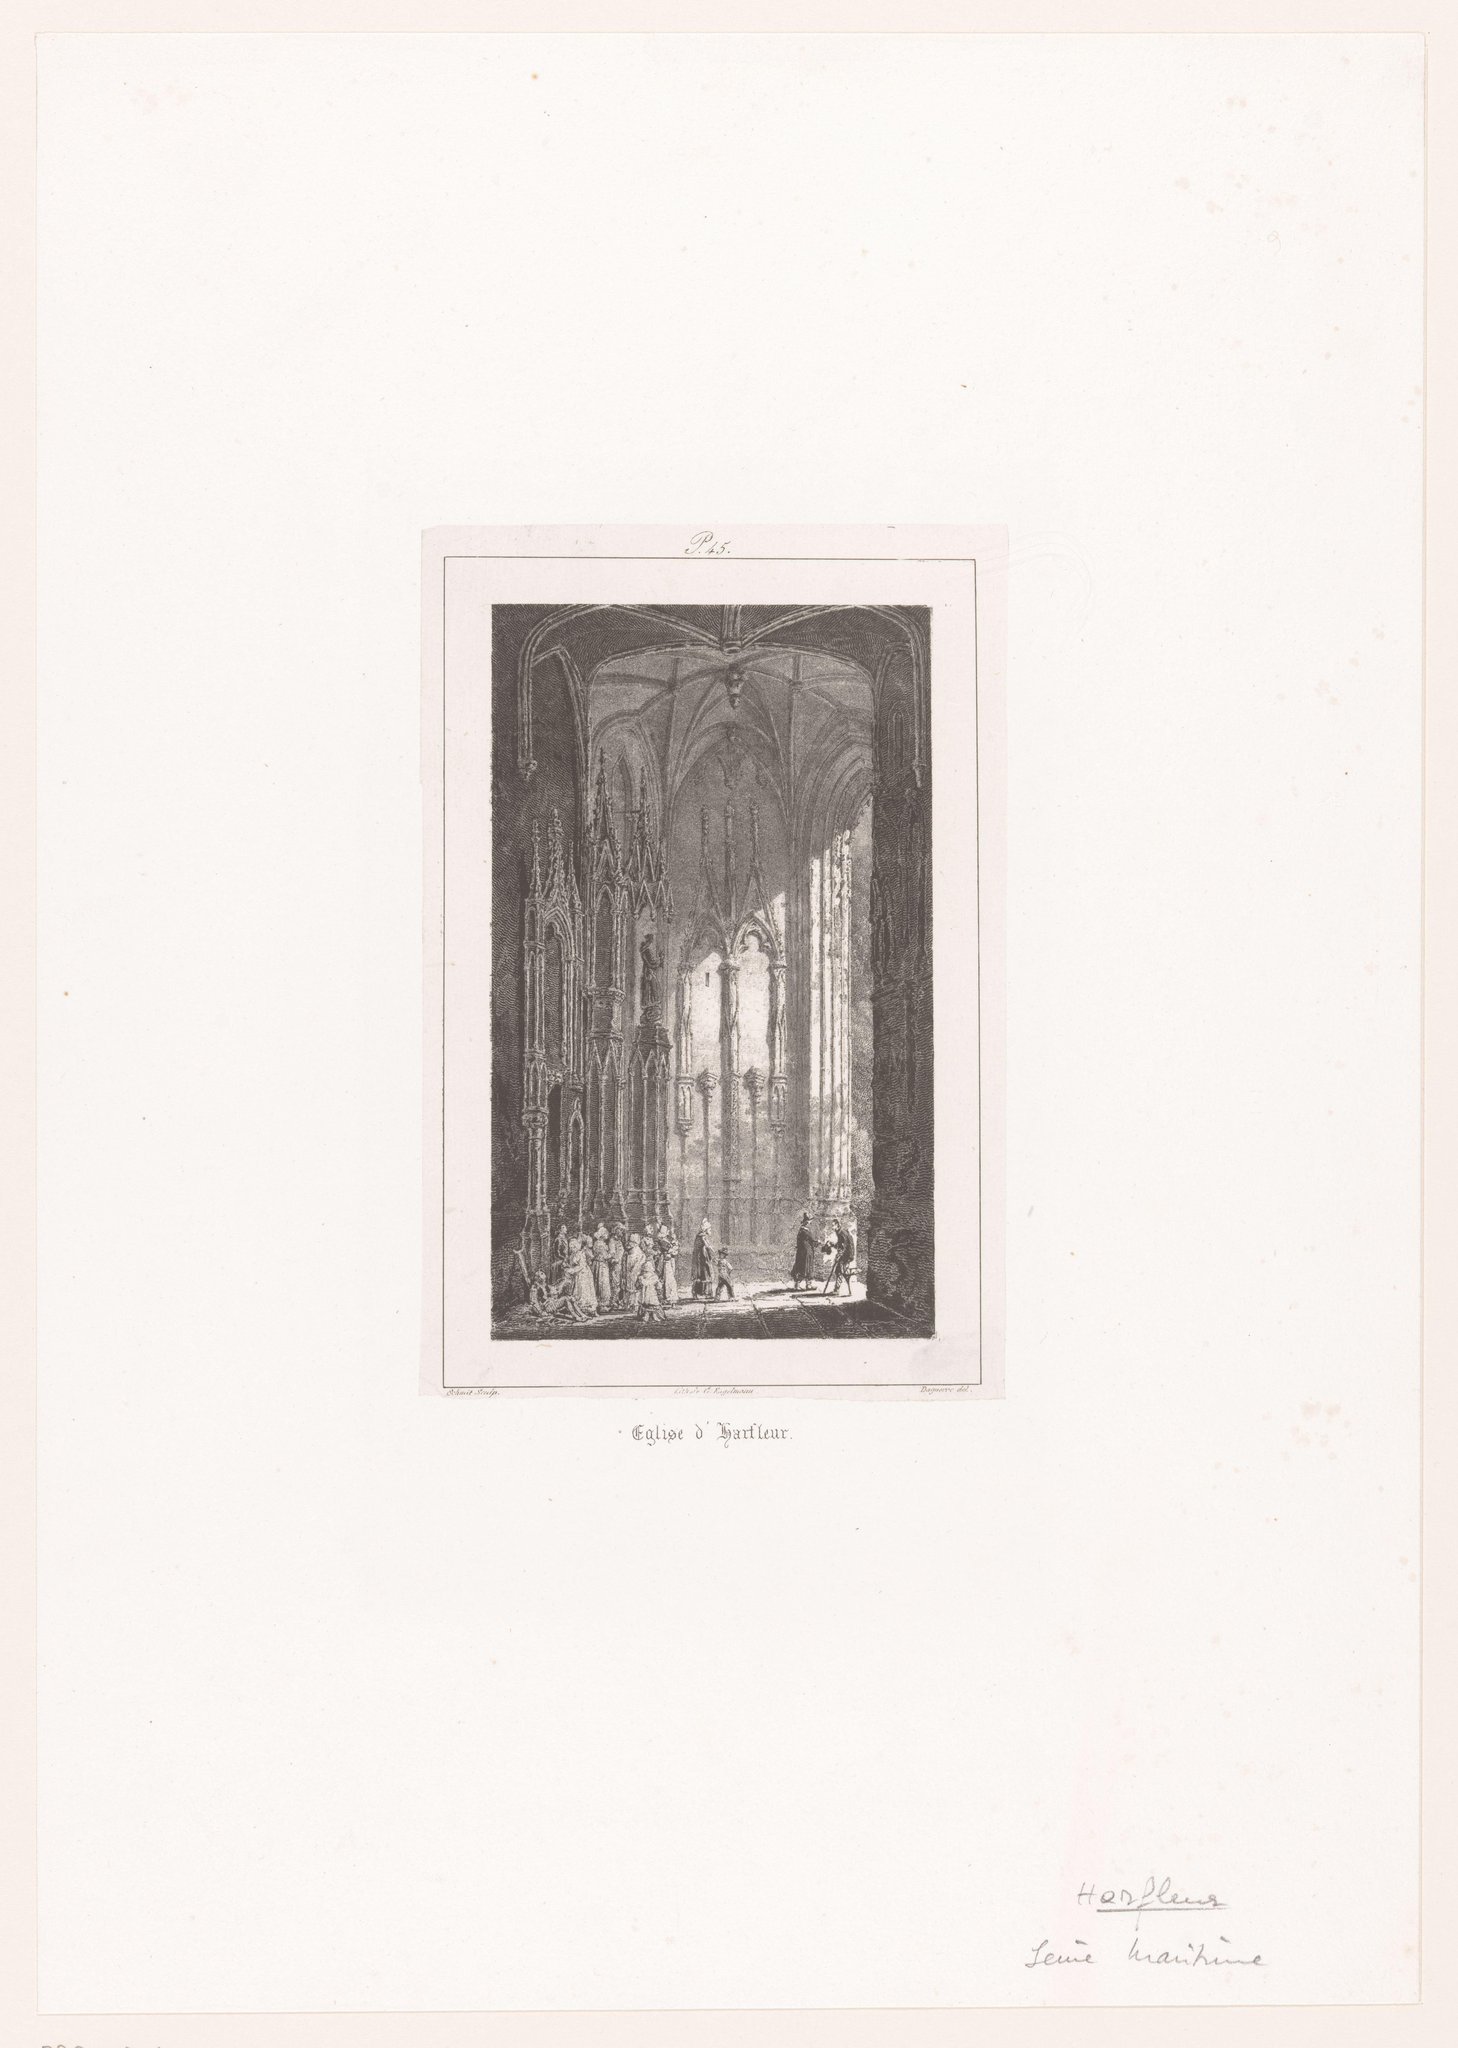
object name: print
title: Église d'Harfleur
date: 1824-1832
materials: paper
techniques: lithograph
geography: france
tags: interior of church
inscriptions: collector's mark: Lugt 2228a, collector's mark: Lugt 2760